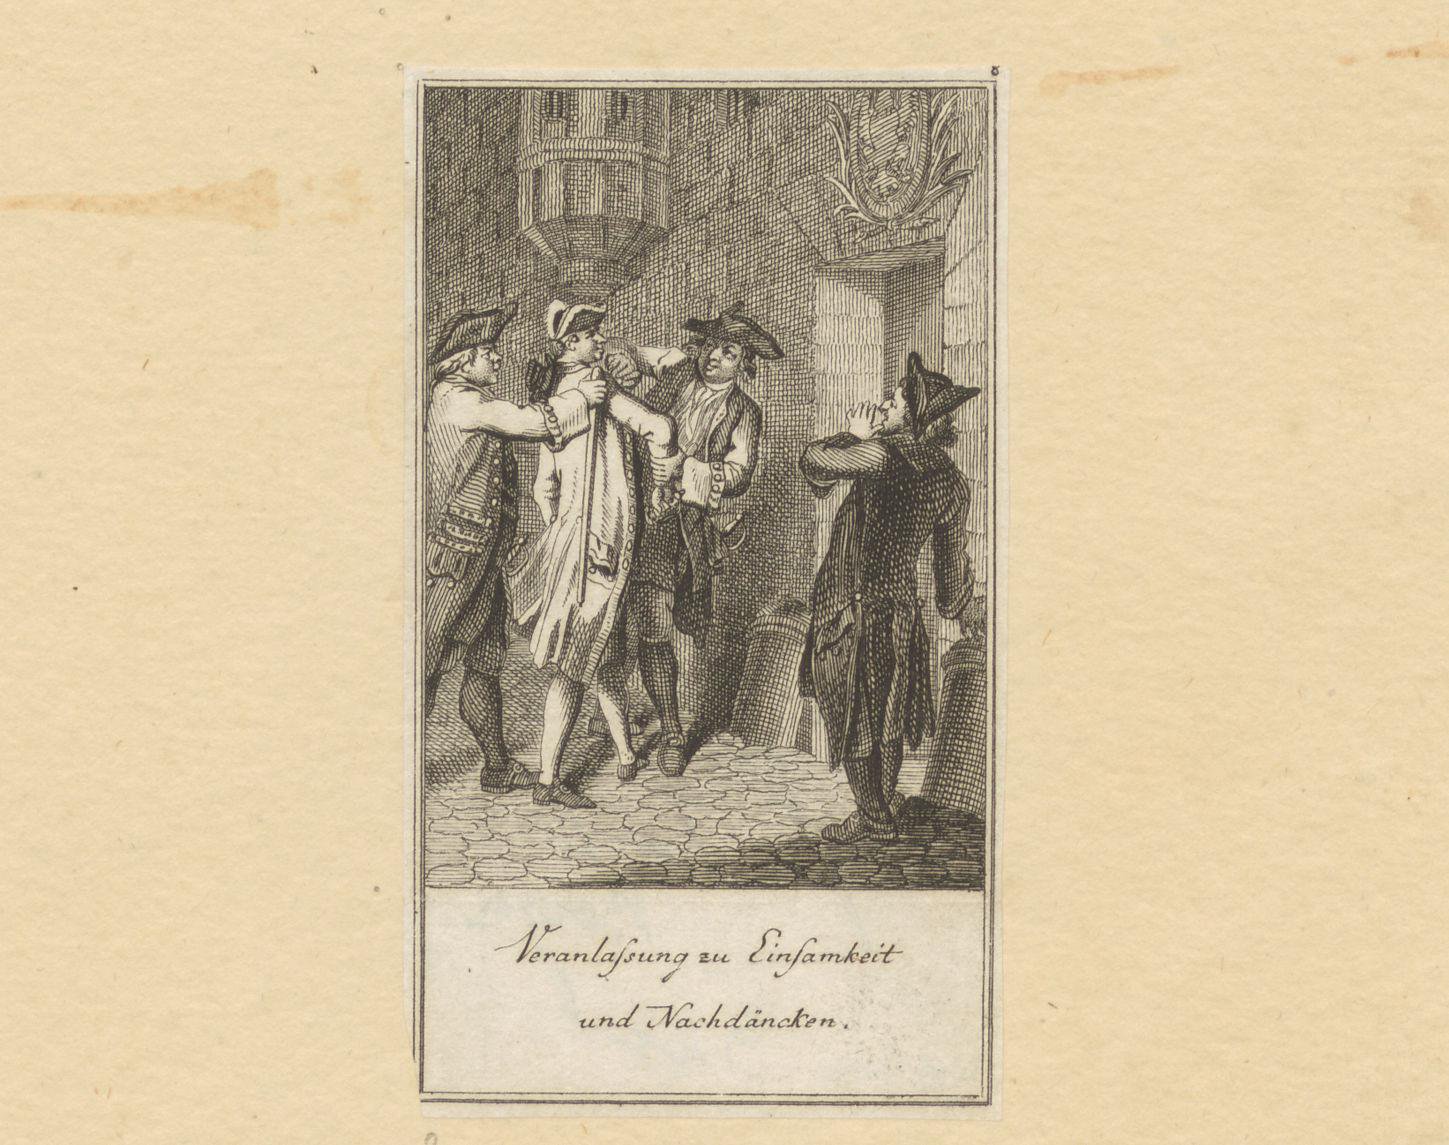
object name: print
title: Veranlassung zu Einsamkeit und Nachdäncken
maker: daniel berger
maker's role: print maker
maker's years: 1744-1824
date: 1773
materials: paper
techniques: etching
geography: berlin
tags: prison, jail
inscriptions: collector's mark: Lugt 2228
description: Prent afkomstig uit: Genealogischer Calender auf das Jahr 1774. Mit Genehmigung der Königlichen Academie der Wissenschaften zu Berlin herausgegeben. Achtste scène uit de serie 'Das Leben eines Lüderlichen', bestaand uit twaalf scènes, gedrukt van een koperplaat.